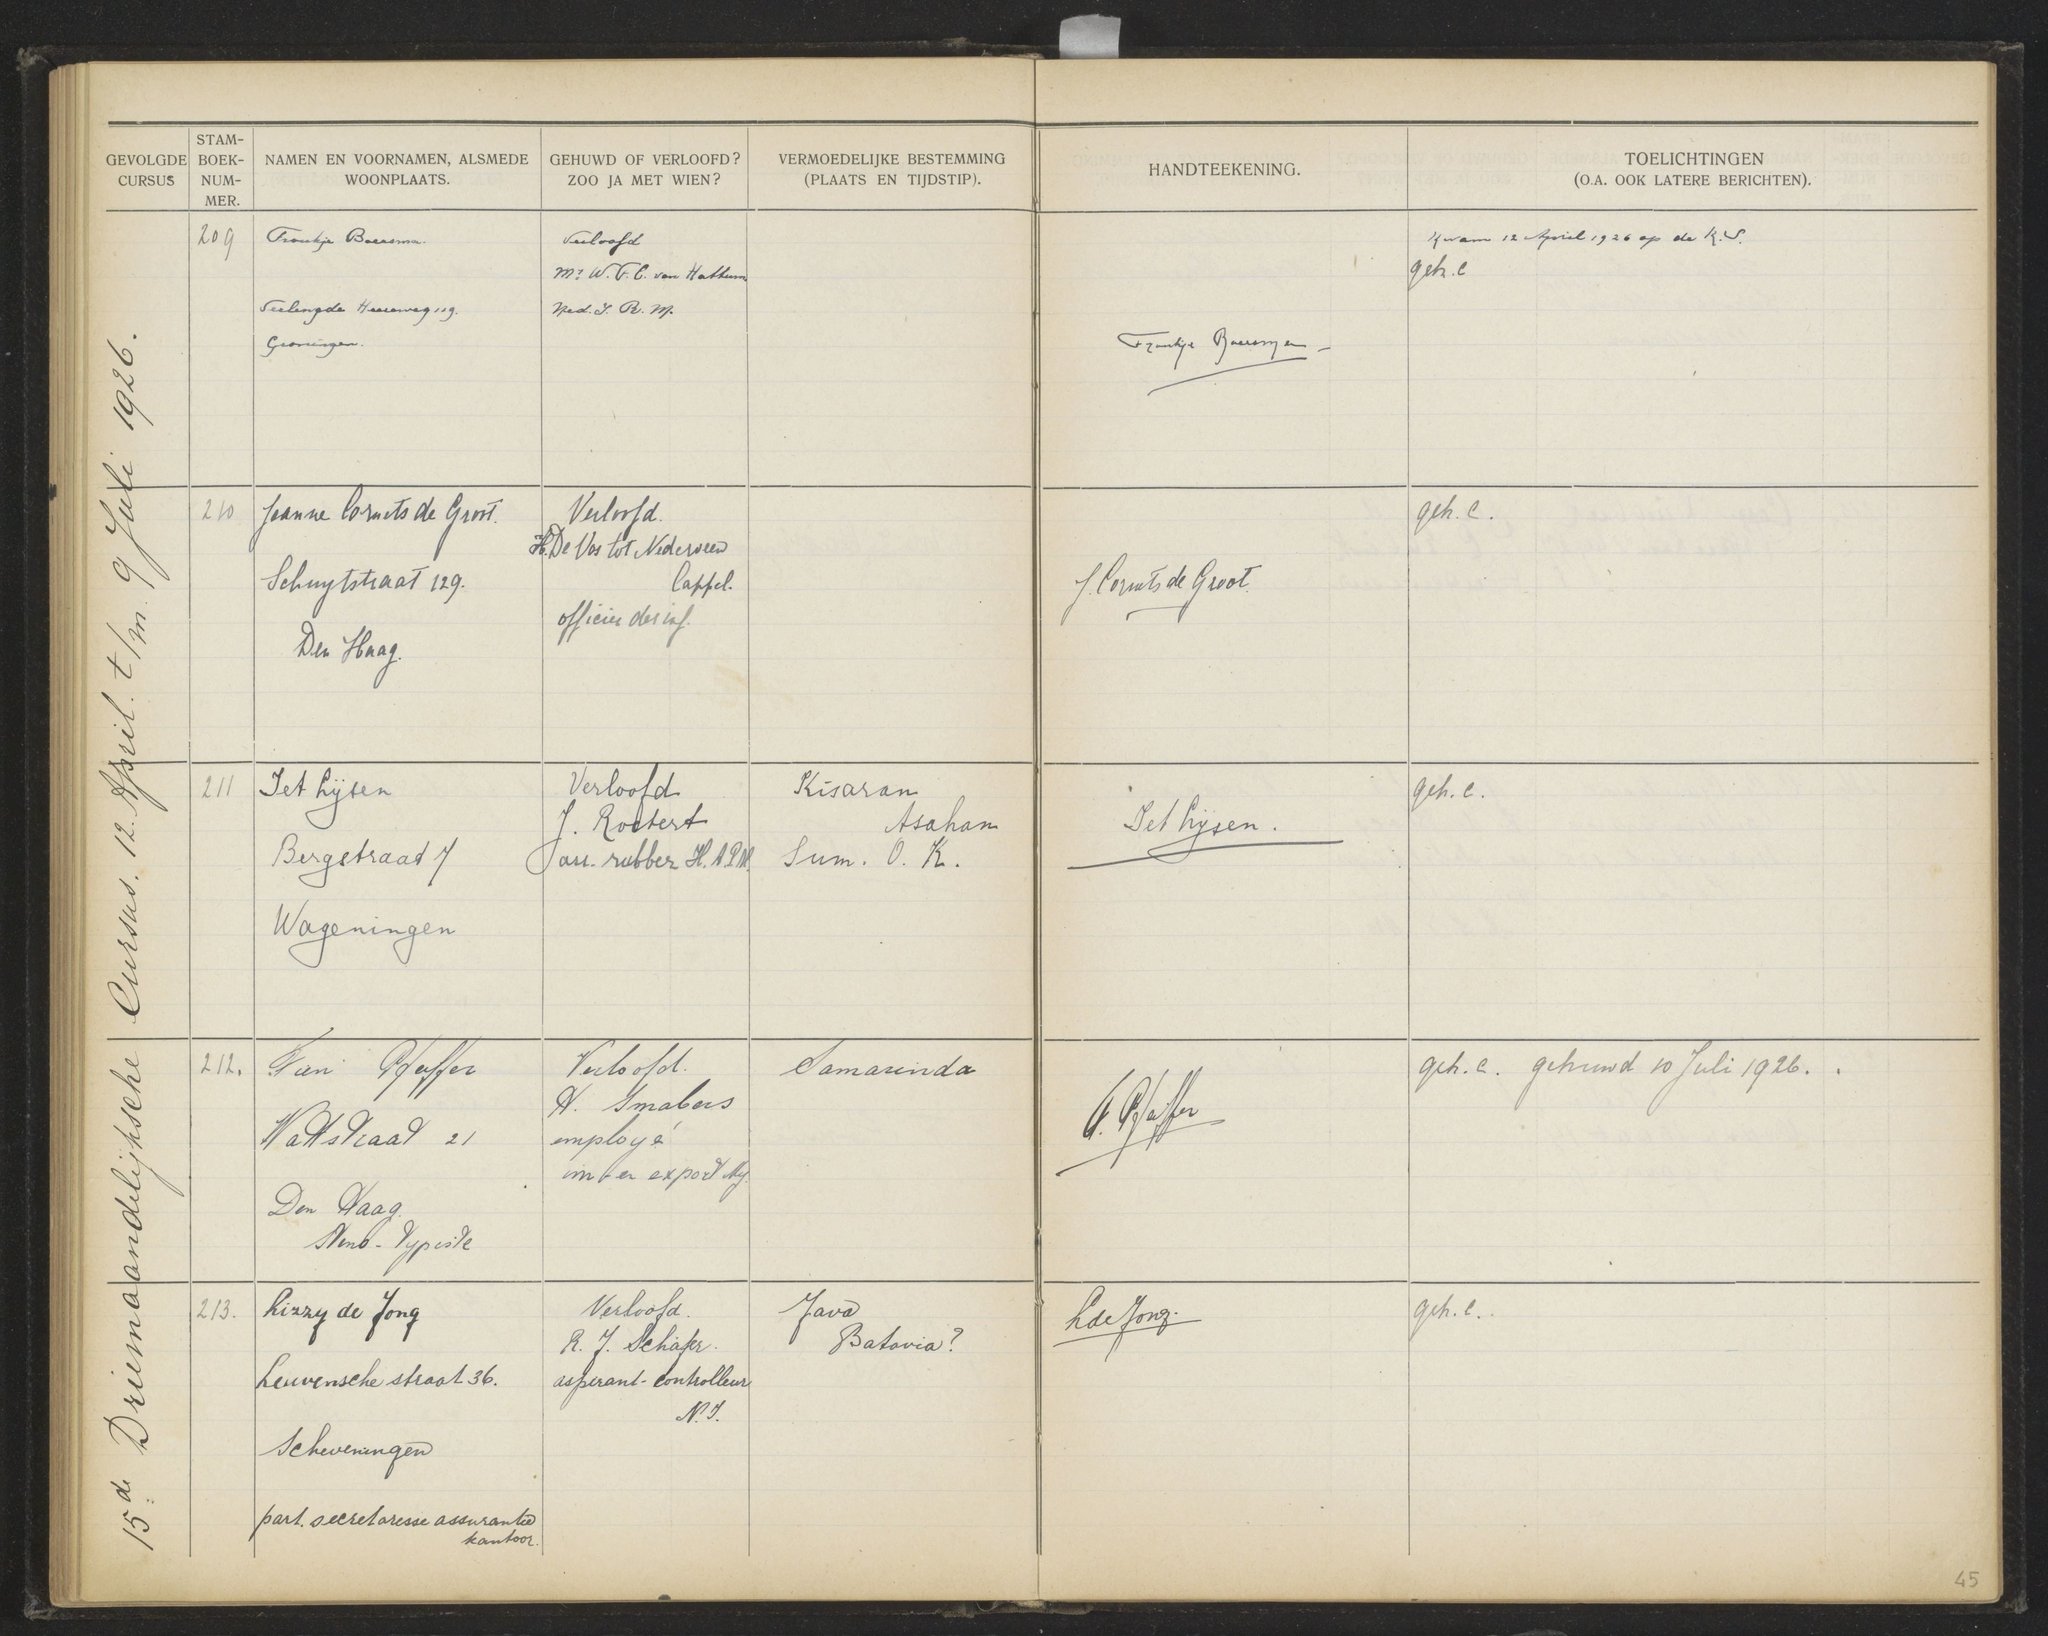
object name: album leaf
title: Blad 45 uit Stamboek van de leerlingen der Koloniale School voor Meisjes en Vrouwen te 's-Gravenhage deel I (1921-1929)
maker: Anonymous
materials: paper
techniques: printing, writing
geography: the hague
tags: further education (+ pupil), further education, the hague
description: Twee pagina's met gegevens van de deelnemers aan de 15e driemaandelijkse cursus resp. van 12 april tot en met 9 juli 1926, stamboeknummers 209 tot en met 213. Onderdeel van Stamboek van de leerlingen der Koloniale School voor Meisjes en Vrouwen te 's-Gravenhage deel I (1921-1929).